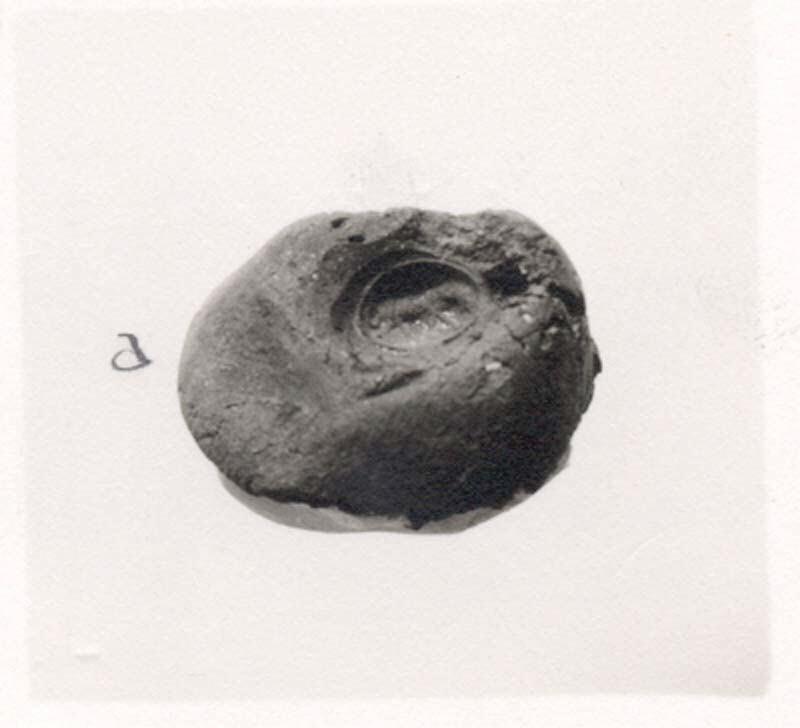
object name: sealing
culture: sasanian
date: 601-700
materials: clay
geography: iran